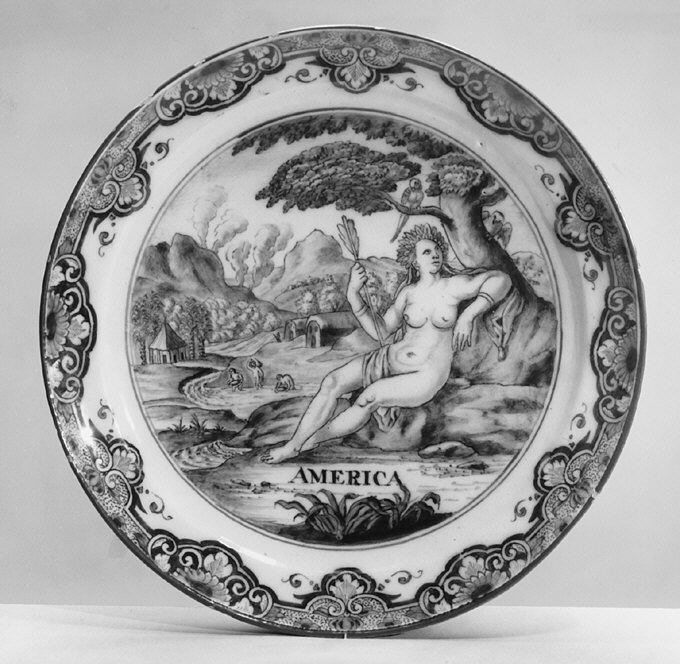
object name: plate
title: America (part of a set of four)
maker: johann sadeler (i)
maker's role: artist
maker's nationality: netherlandish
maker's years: 1550-1601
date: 1667-1733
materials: earthenware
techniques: glazing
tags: birds,female nudes,landscapes,trees